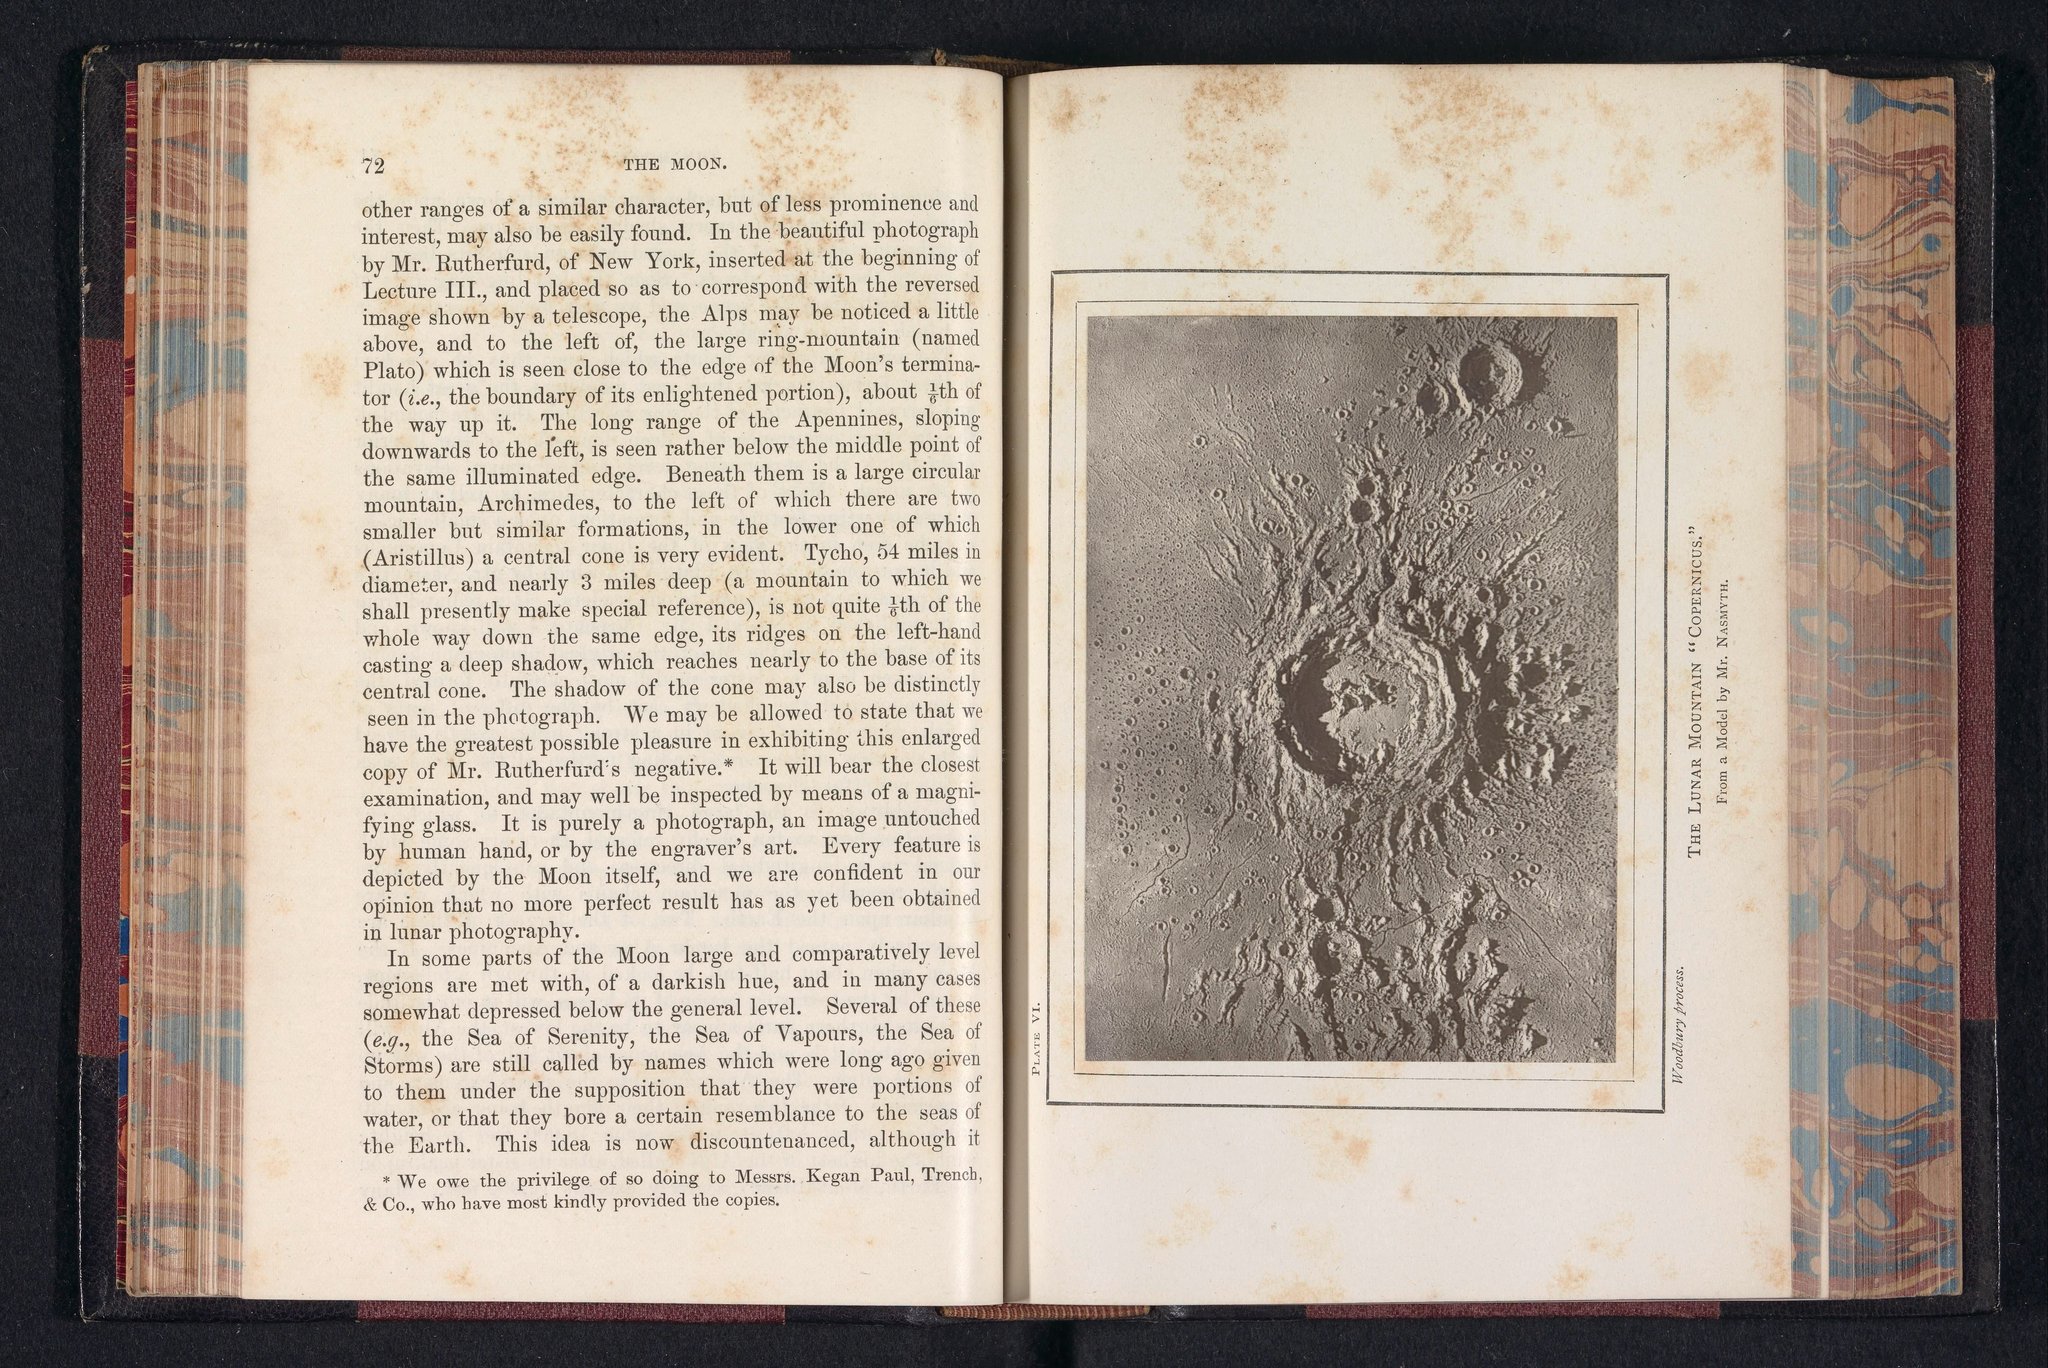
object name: page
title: Gipsmodel van de maankrater Copernicus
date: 1870-1882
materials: paper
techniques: woodburytype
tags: surface of the moon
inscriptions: number: ‘Plate VI.’